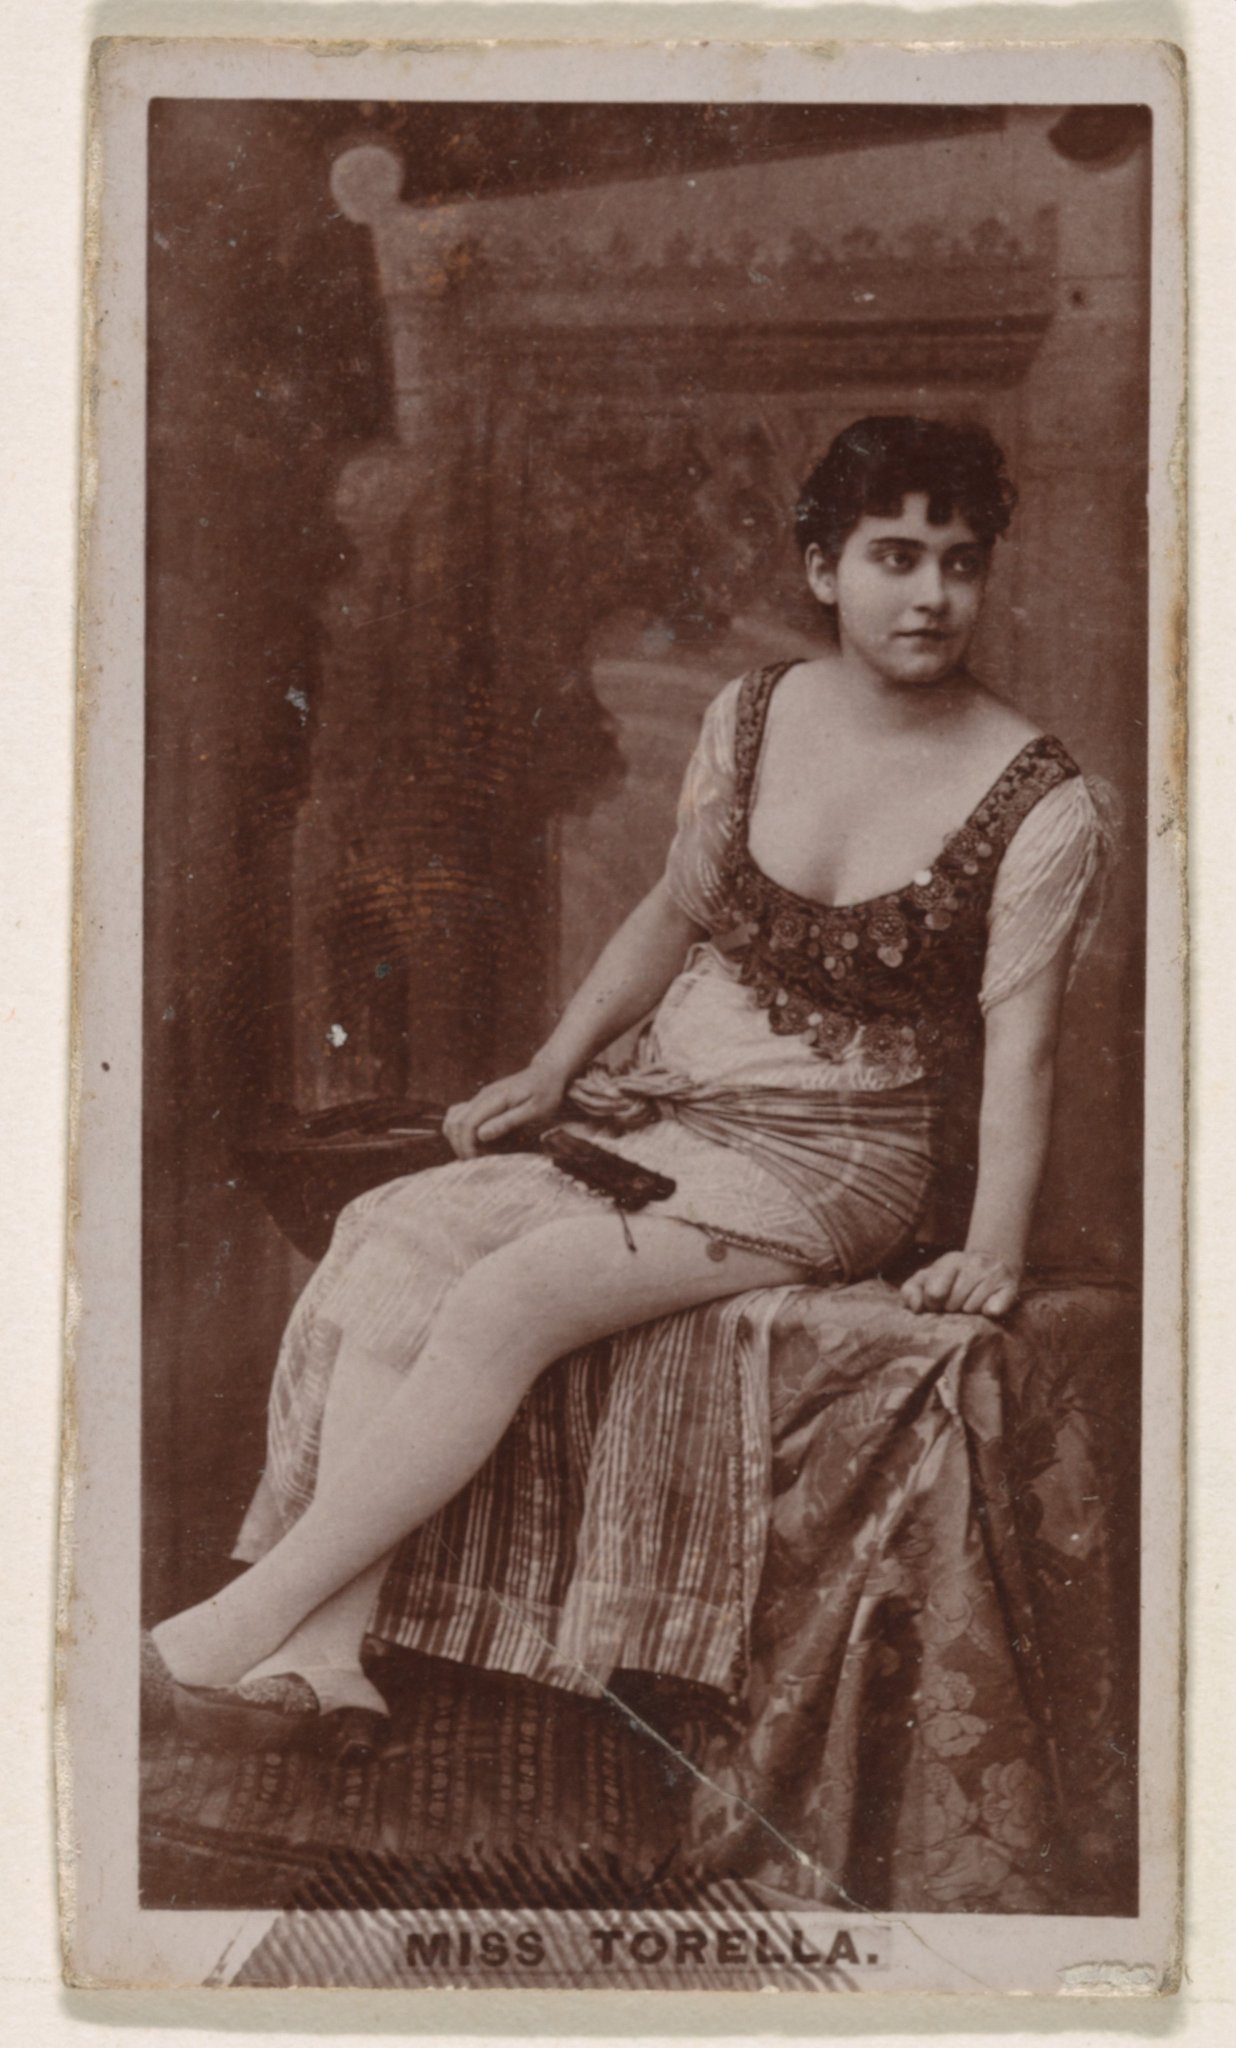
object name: photograph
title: Miss Torella, from the Actresses series (N245) issued by Kinney Brothers to promote Sweet Caporal Cigarettes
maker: kinney brothers tobacco company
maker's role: publisher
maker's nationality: american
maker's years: 1869-2011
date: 1890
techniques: albumen silver print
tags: portraits,women,actresses